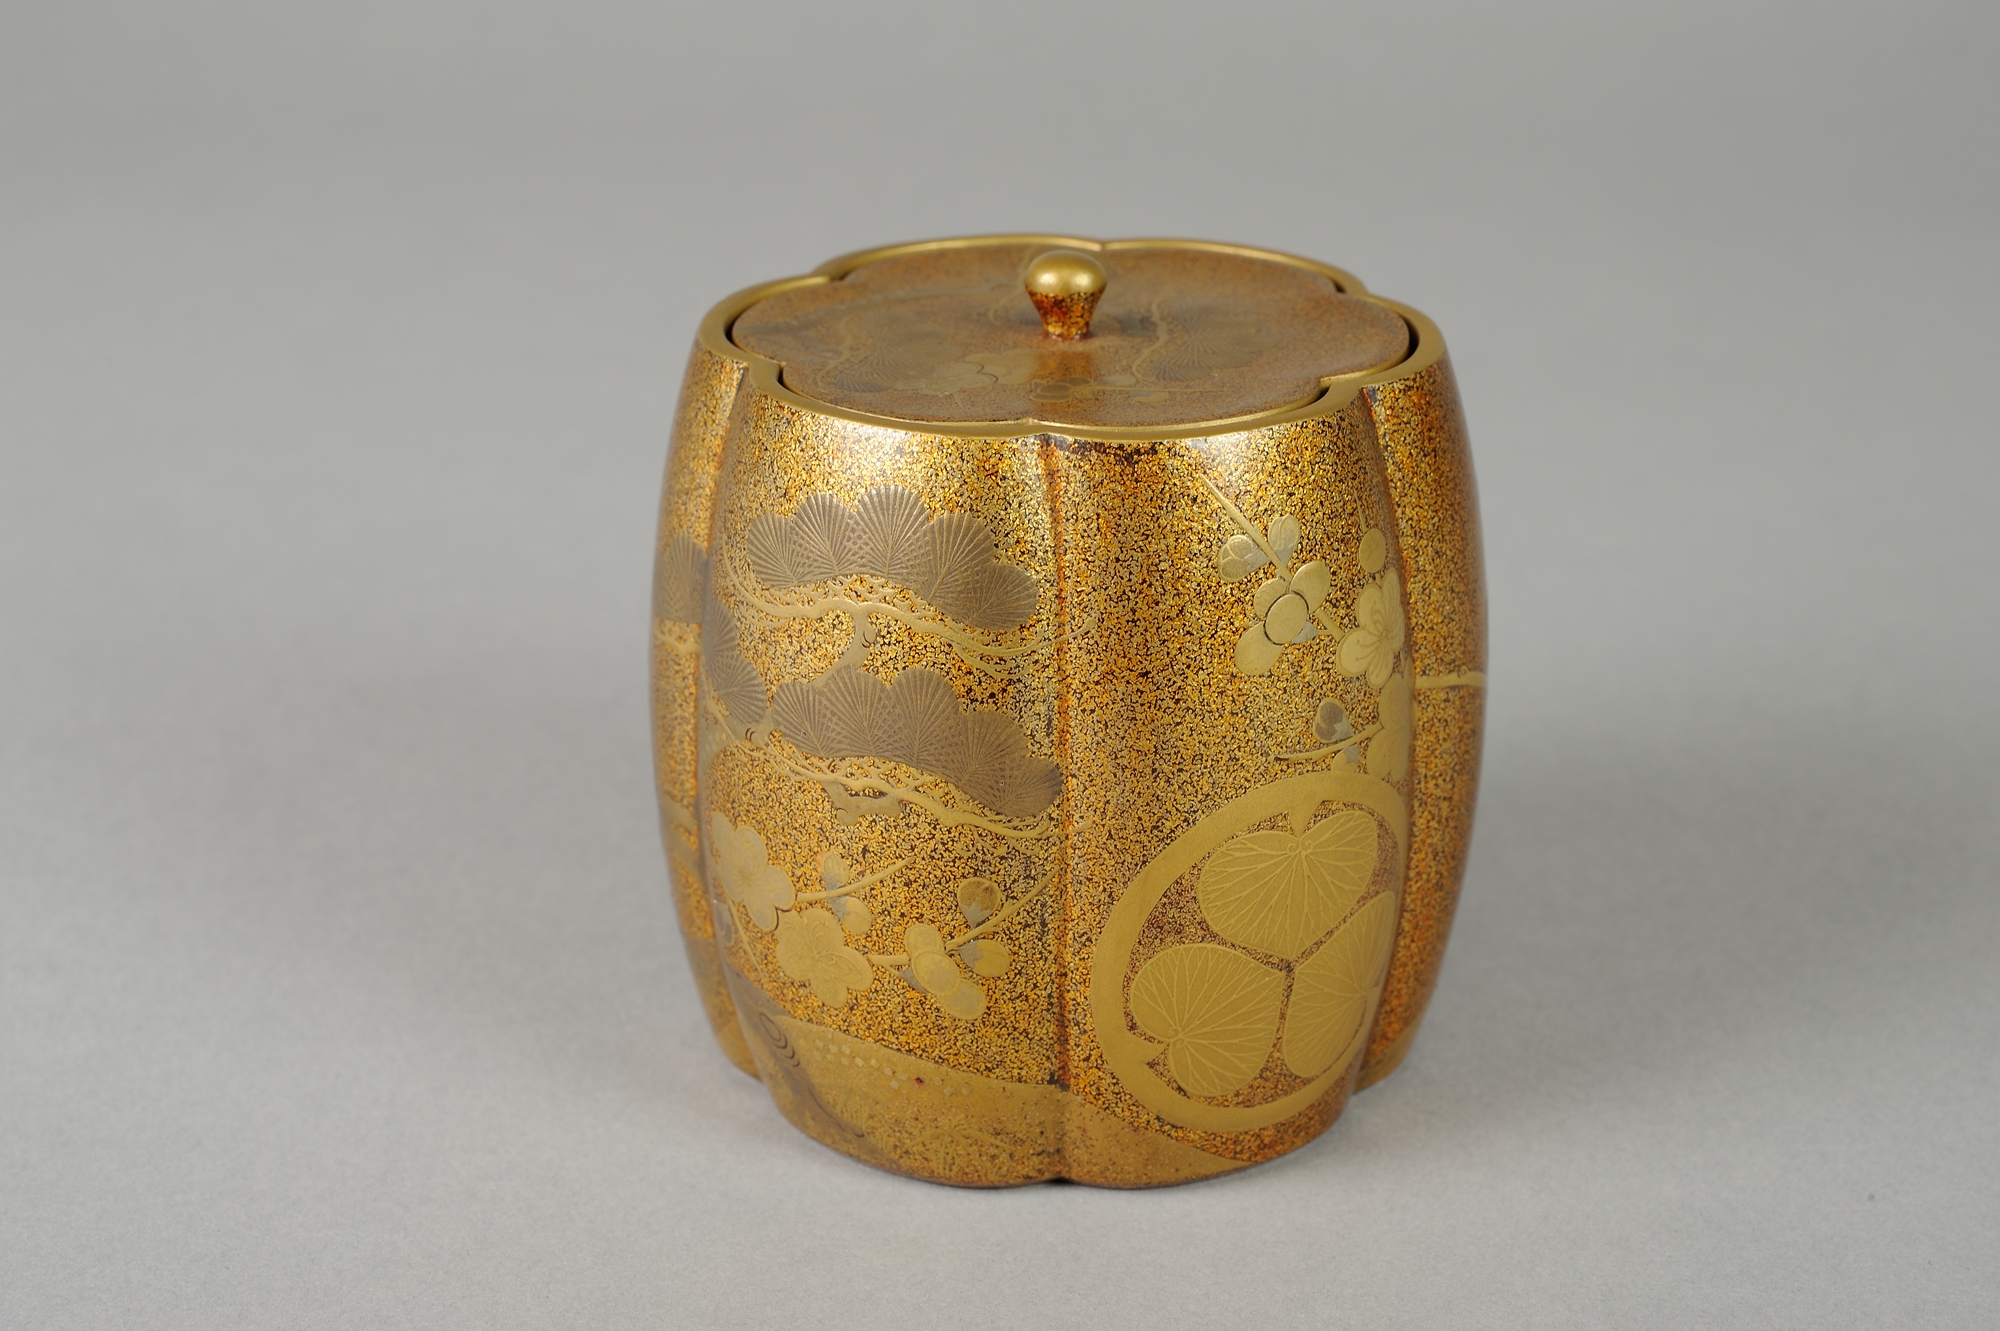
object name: incense ash pot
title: Incense Ash-Pot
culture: japanese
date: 1801-1900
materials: lacquer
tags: flowers